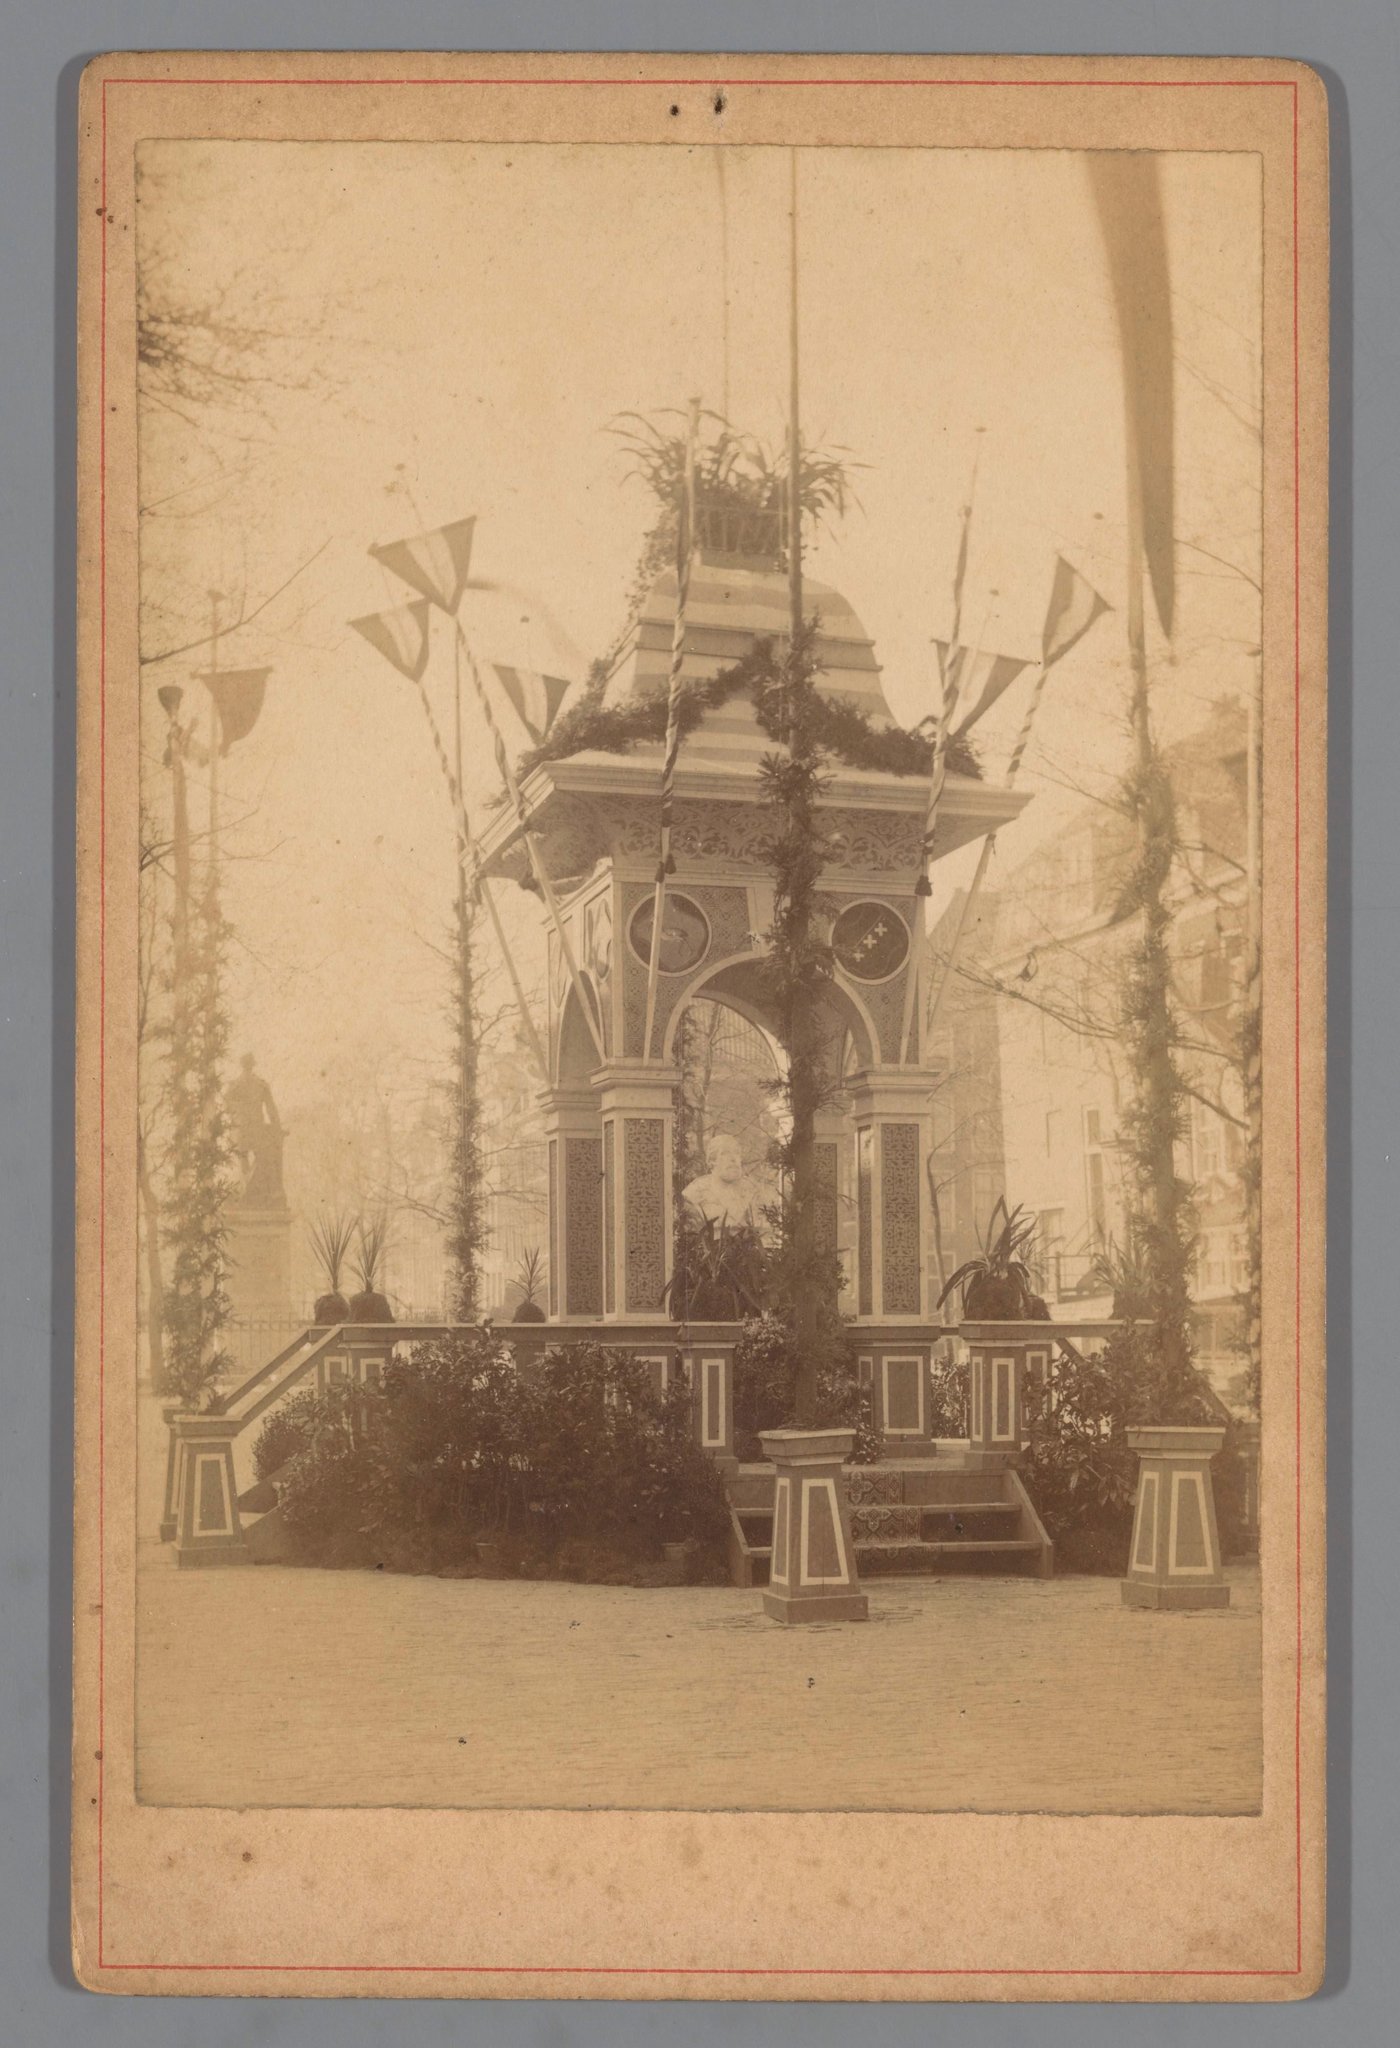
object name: photograph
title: Versierde boog op het Thorbeckeplein in Amsterdam tijdens de Aprilfeesten van 1887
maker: andreas theodorus rooswinkel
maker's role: fotograaf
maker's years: 1838-1909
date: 1804-1887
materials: cardboard, photographic support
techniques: albumen print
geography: amsterdam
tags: arch, archivolt ~ architecture, commemoration, jubilee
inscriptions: name: ‘A.T. ROOSWINKEL.’, annotation: ‘Versieringen 1887./ Thorbeckeplein’